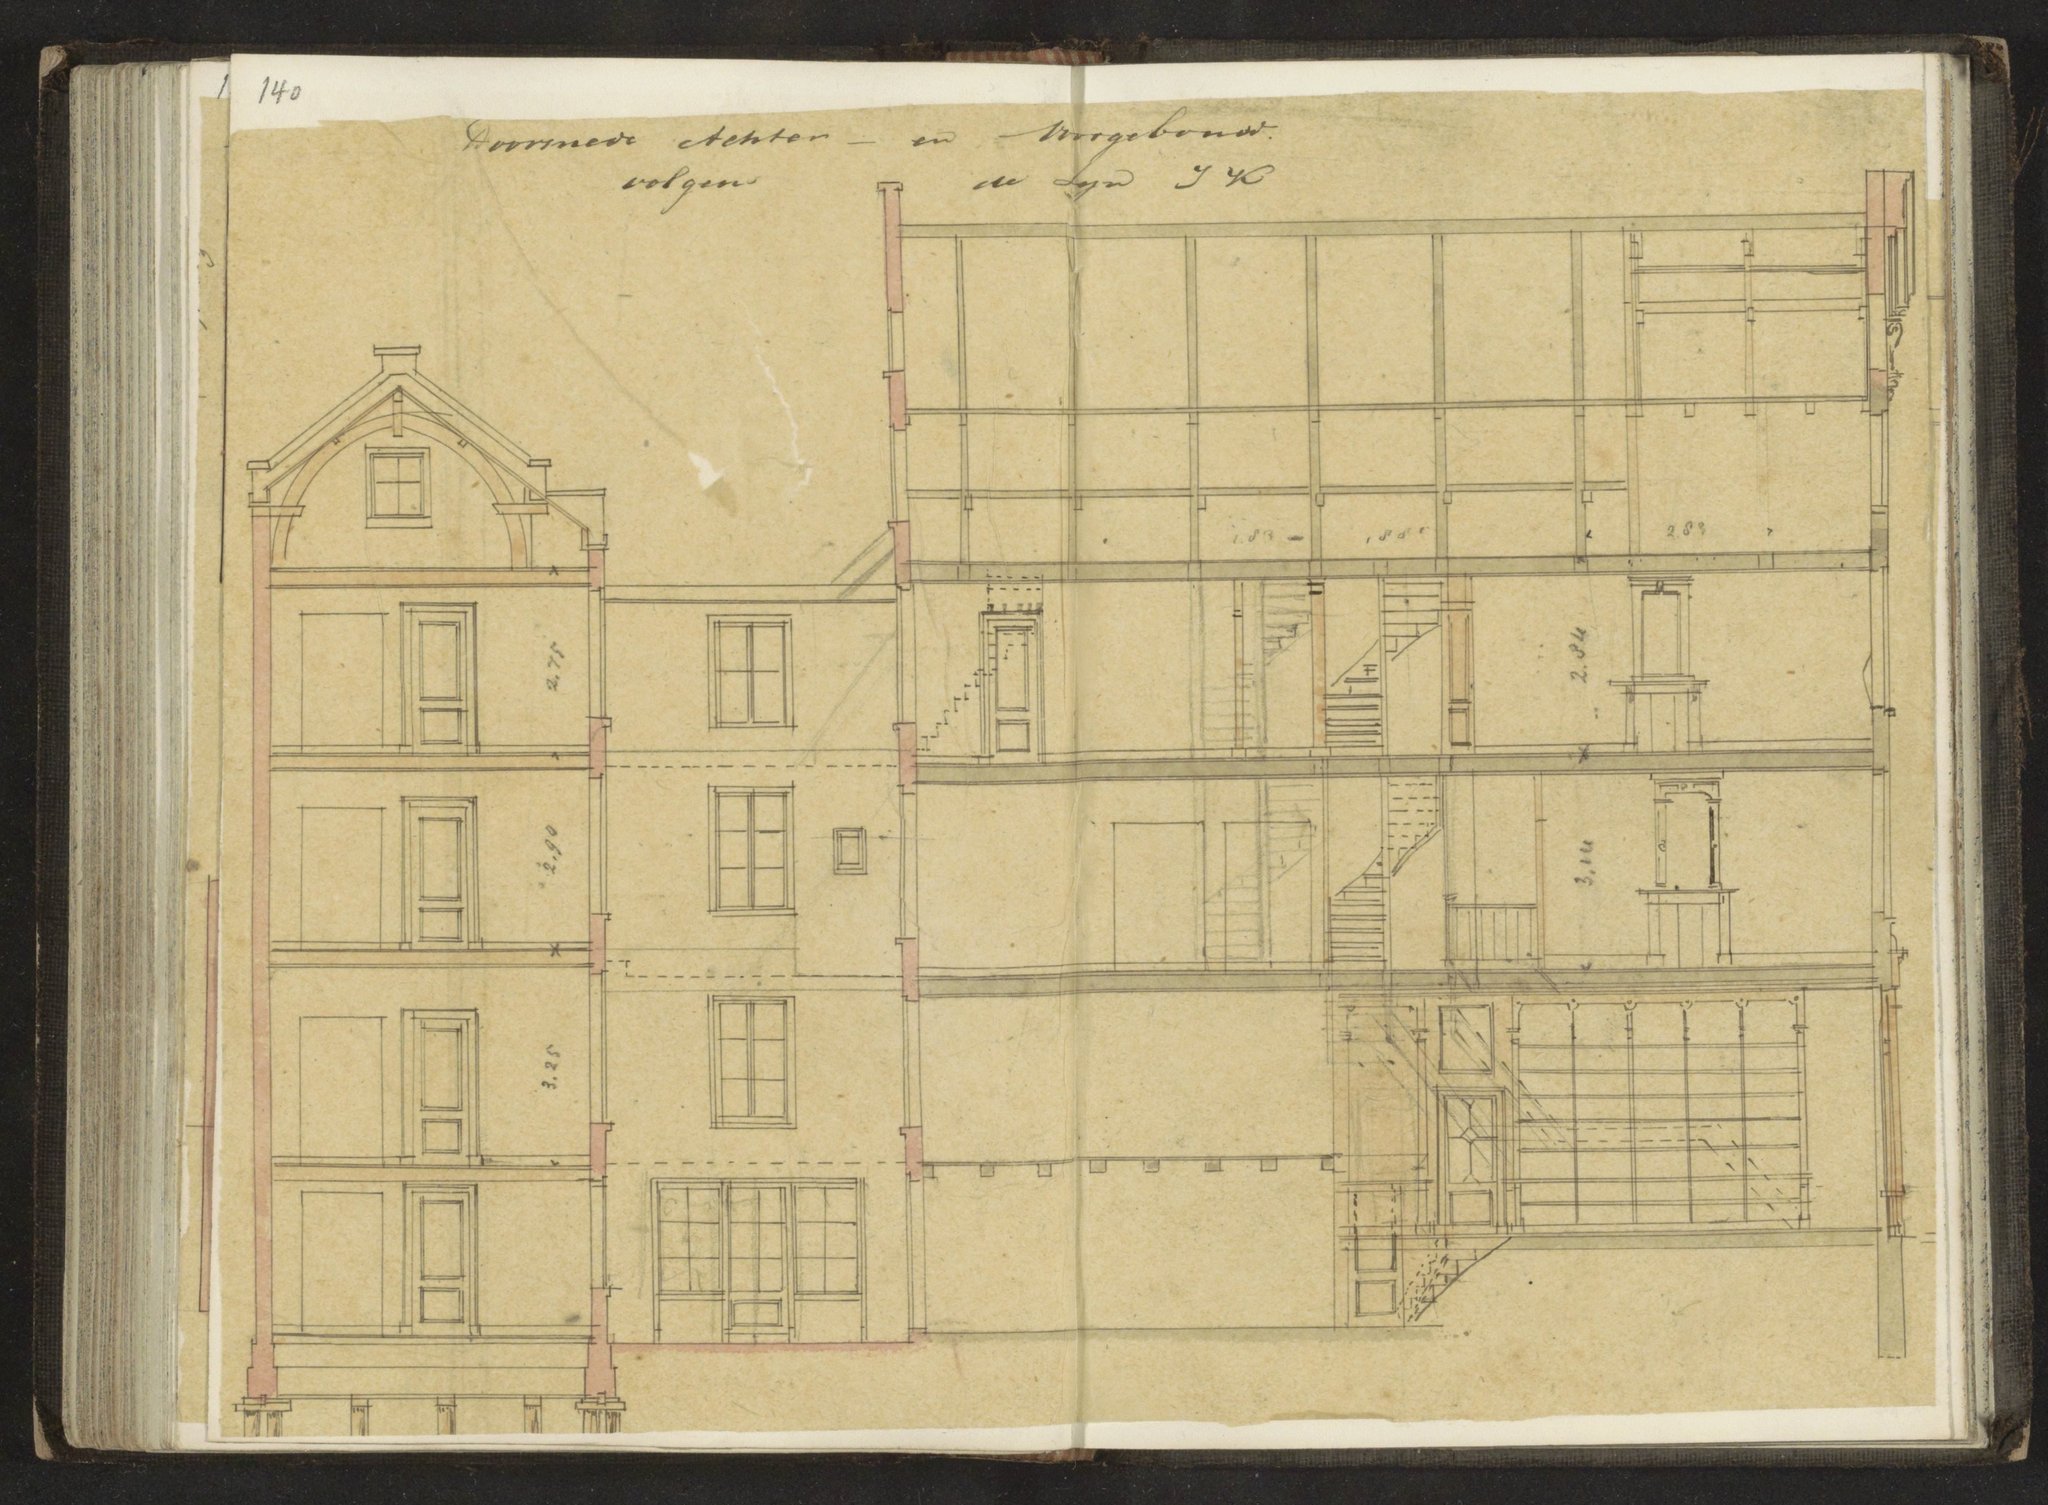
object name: sketchbook leaf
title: Doorsnede van een achter- en voorgebouw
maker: willem springer jr.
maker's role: draughtsman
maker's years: 1815-1907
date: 1864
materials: ink, paper, pencil, watercolor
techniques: brush, pen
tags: section ~ architectural design or model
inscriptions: annotation: ‘Doorsnede Achter - en voorgebouw/ volgens de Lijn JK/ ...’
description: Pagina 140 en 141 uit een schetsboek met 164 pagina's.